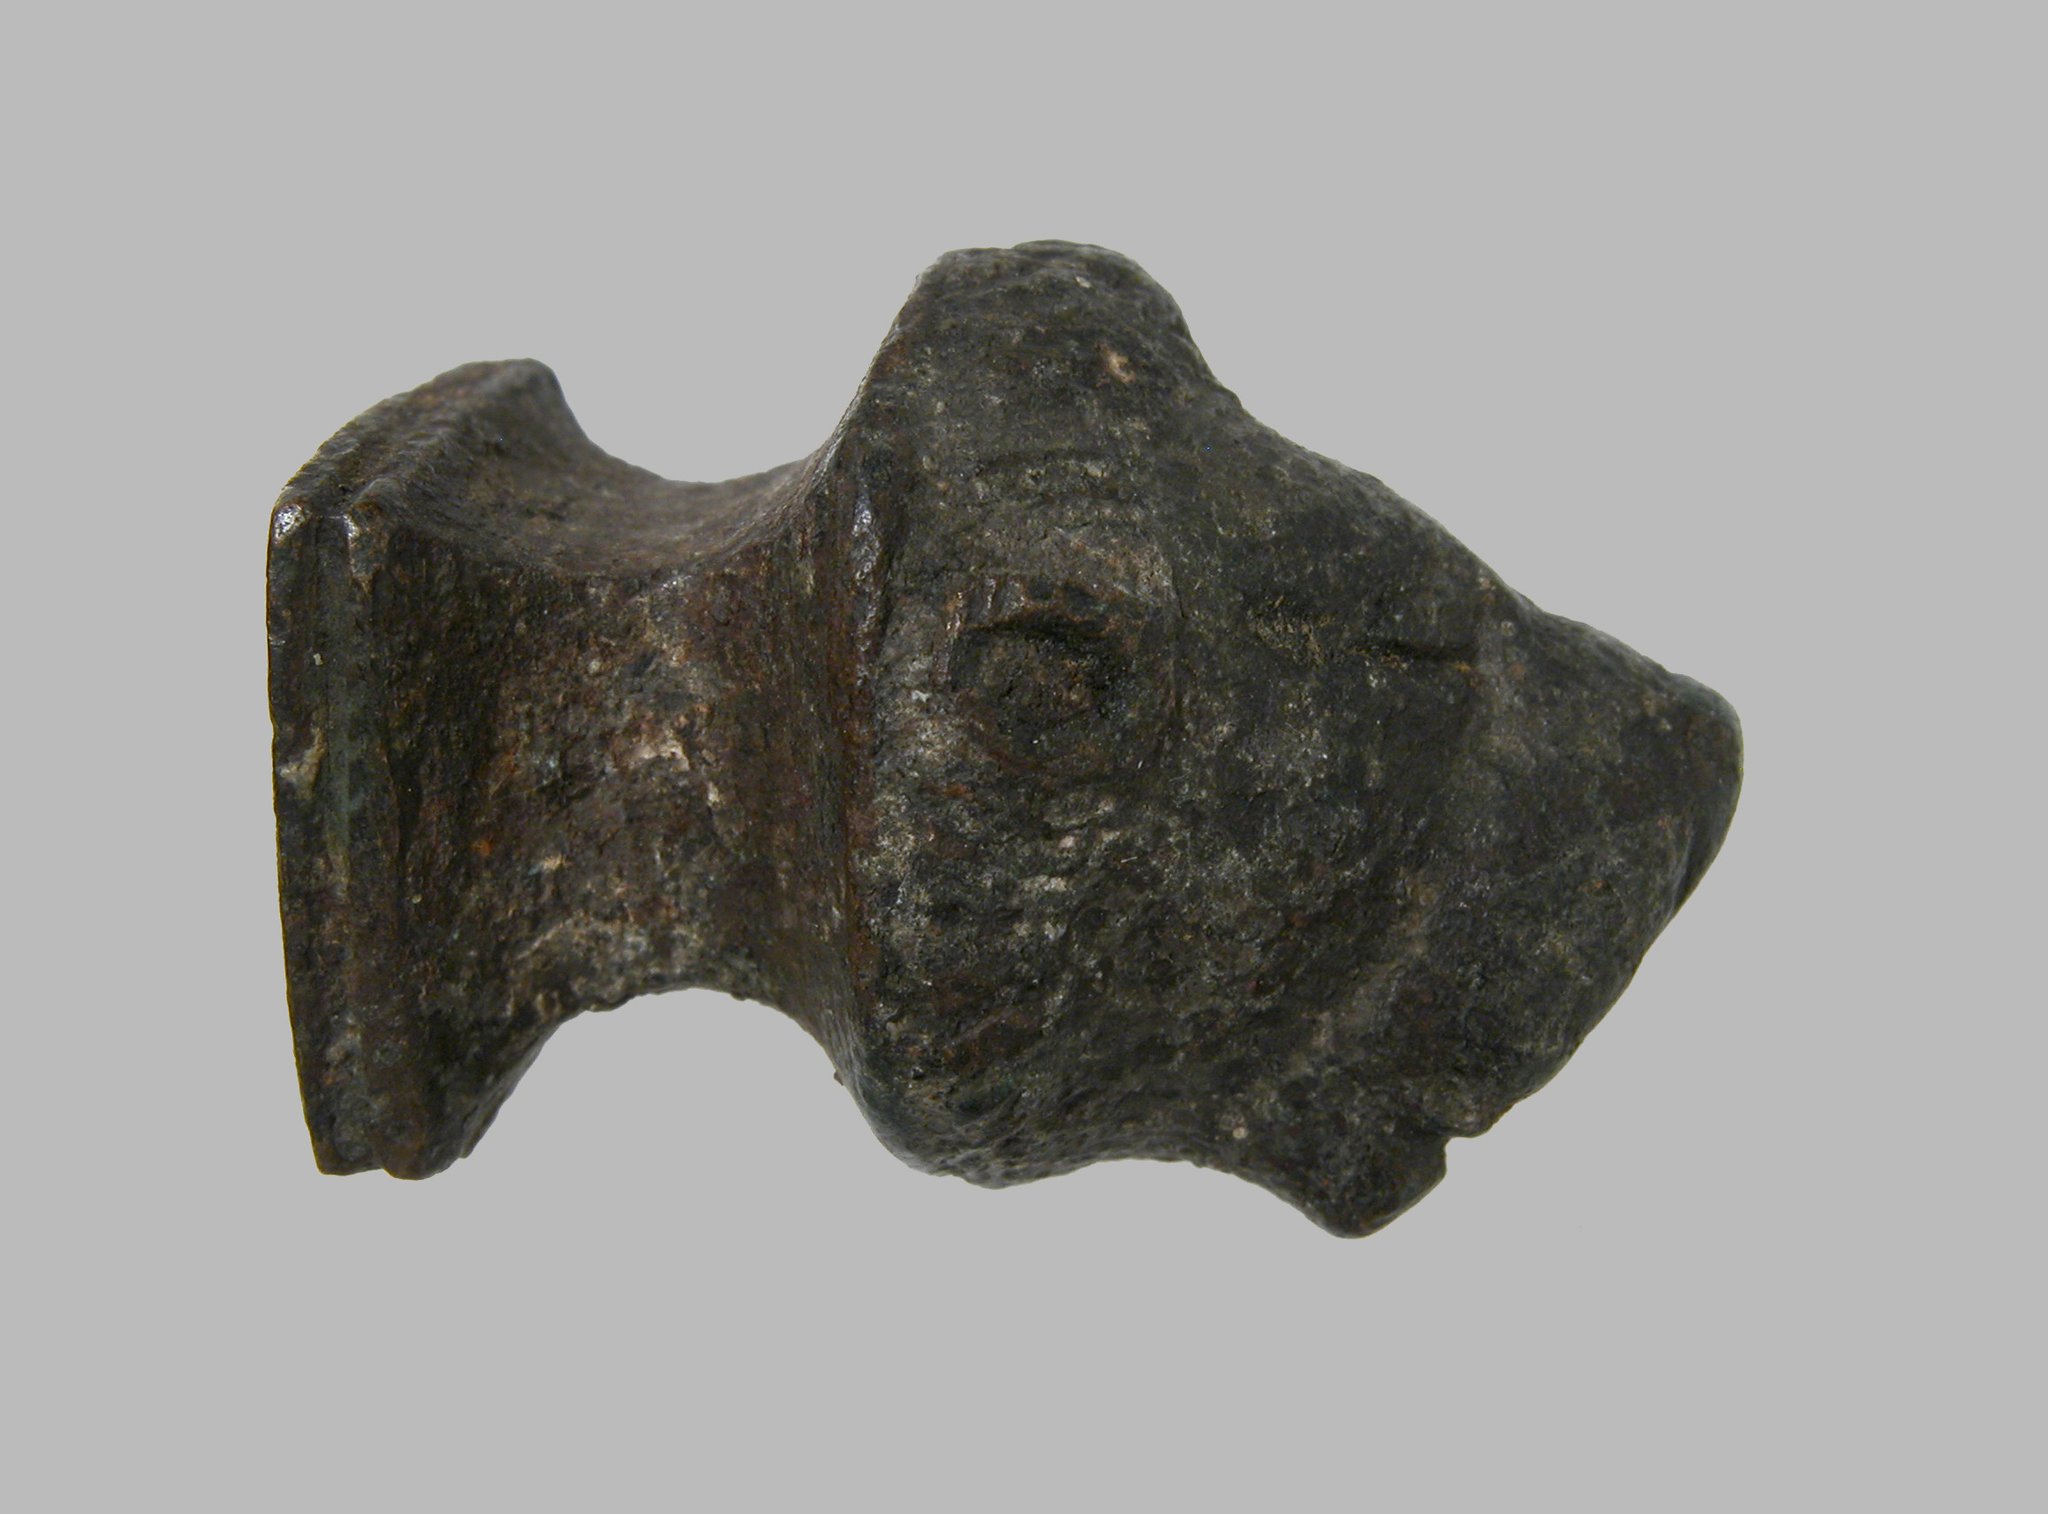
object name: key handle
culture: roman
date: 1-700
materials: copper alloy